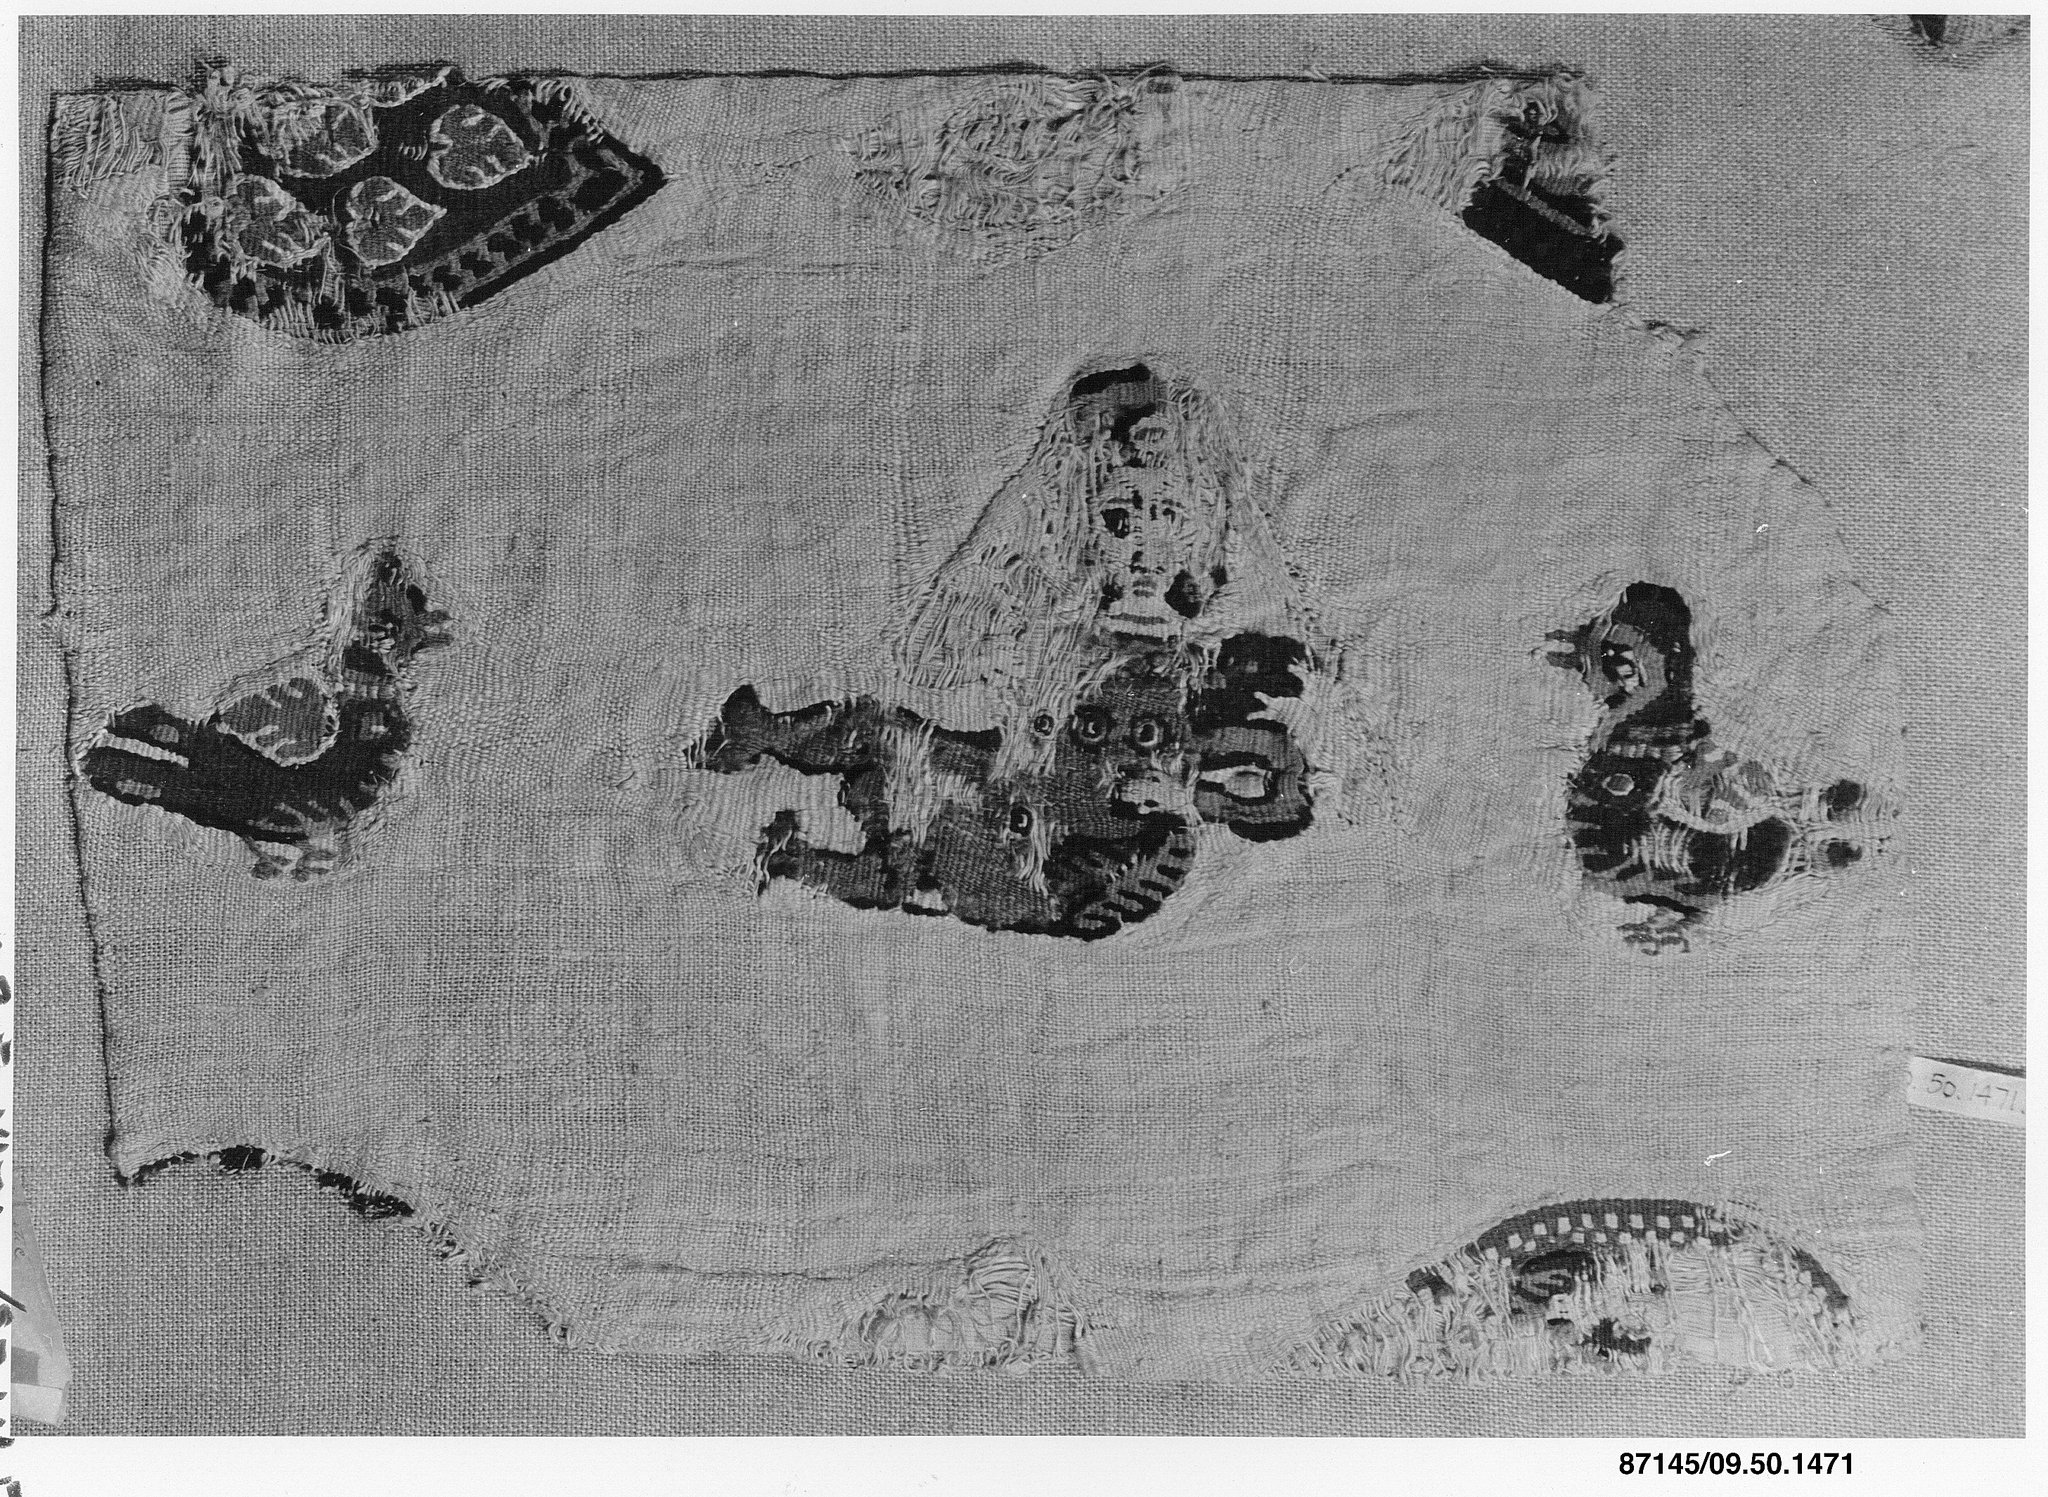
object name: textile fragment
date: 401-600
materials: linen, wool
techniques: weave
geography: egypt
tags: birds